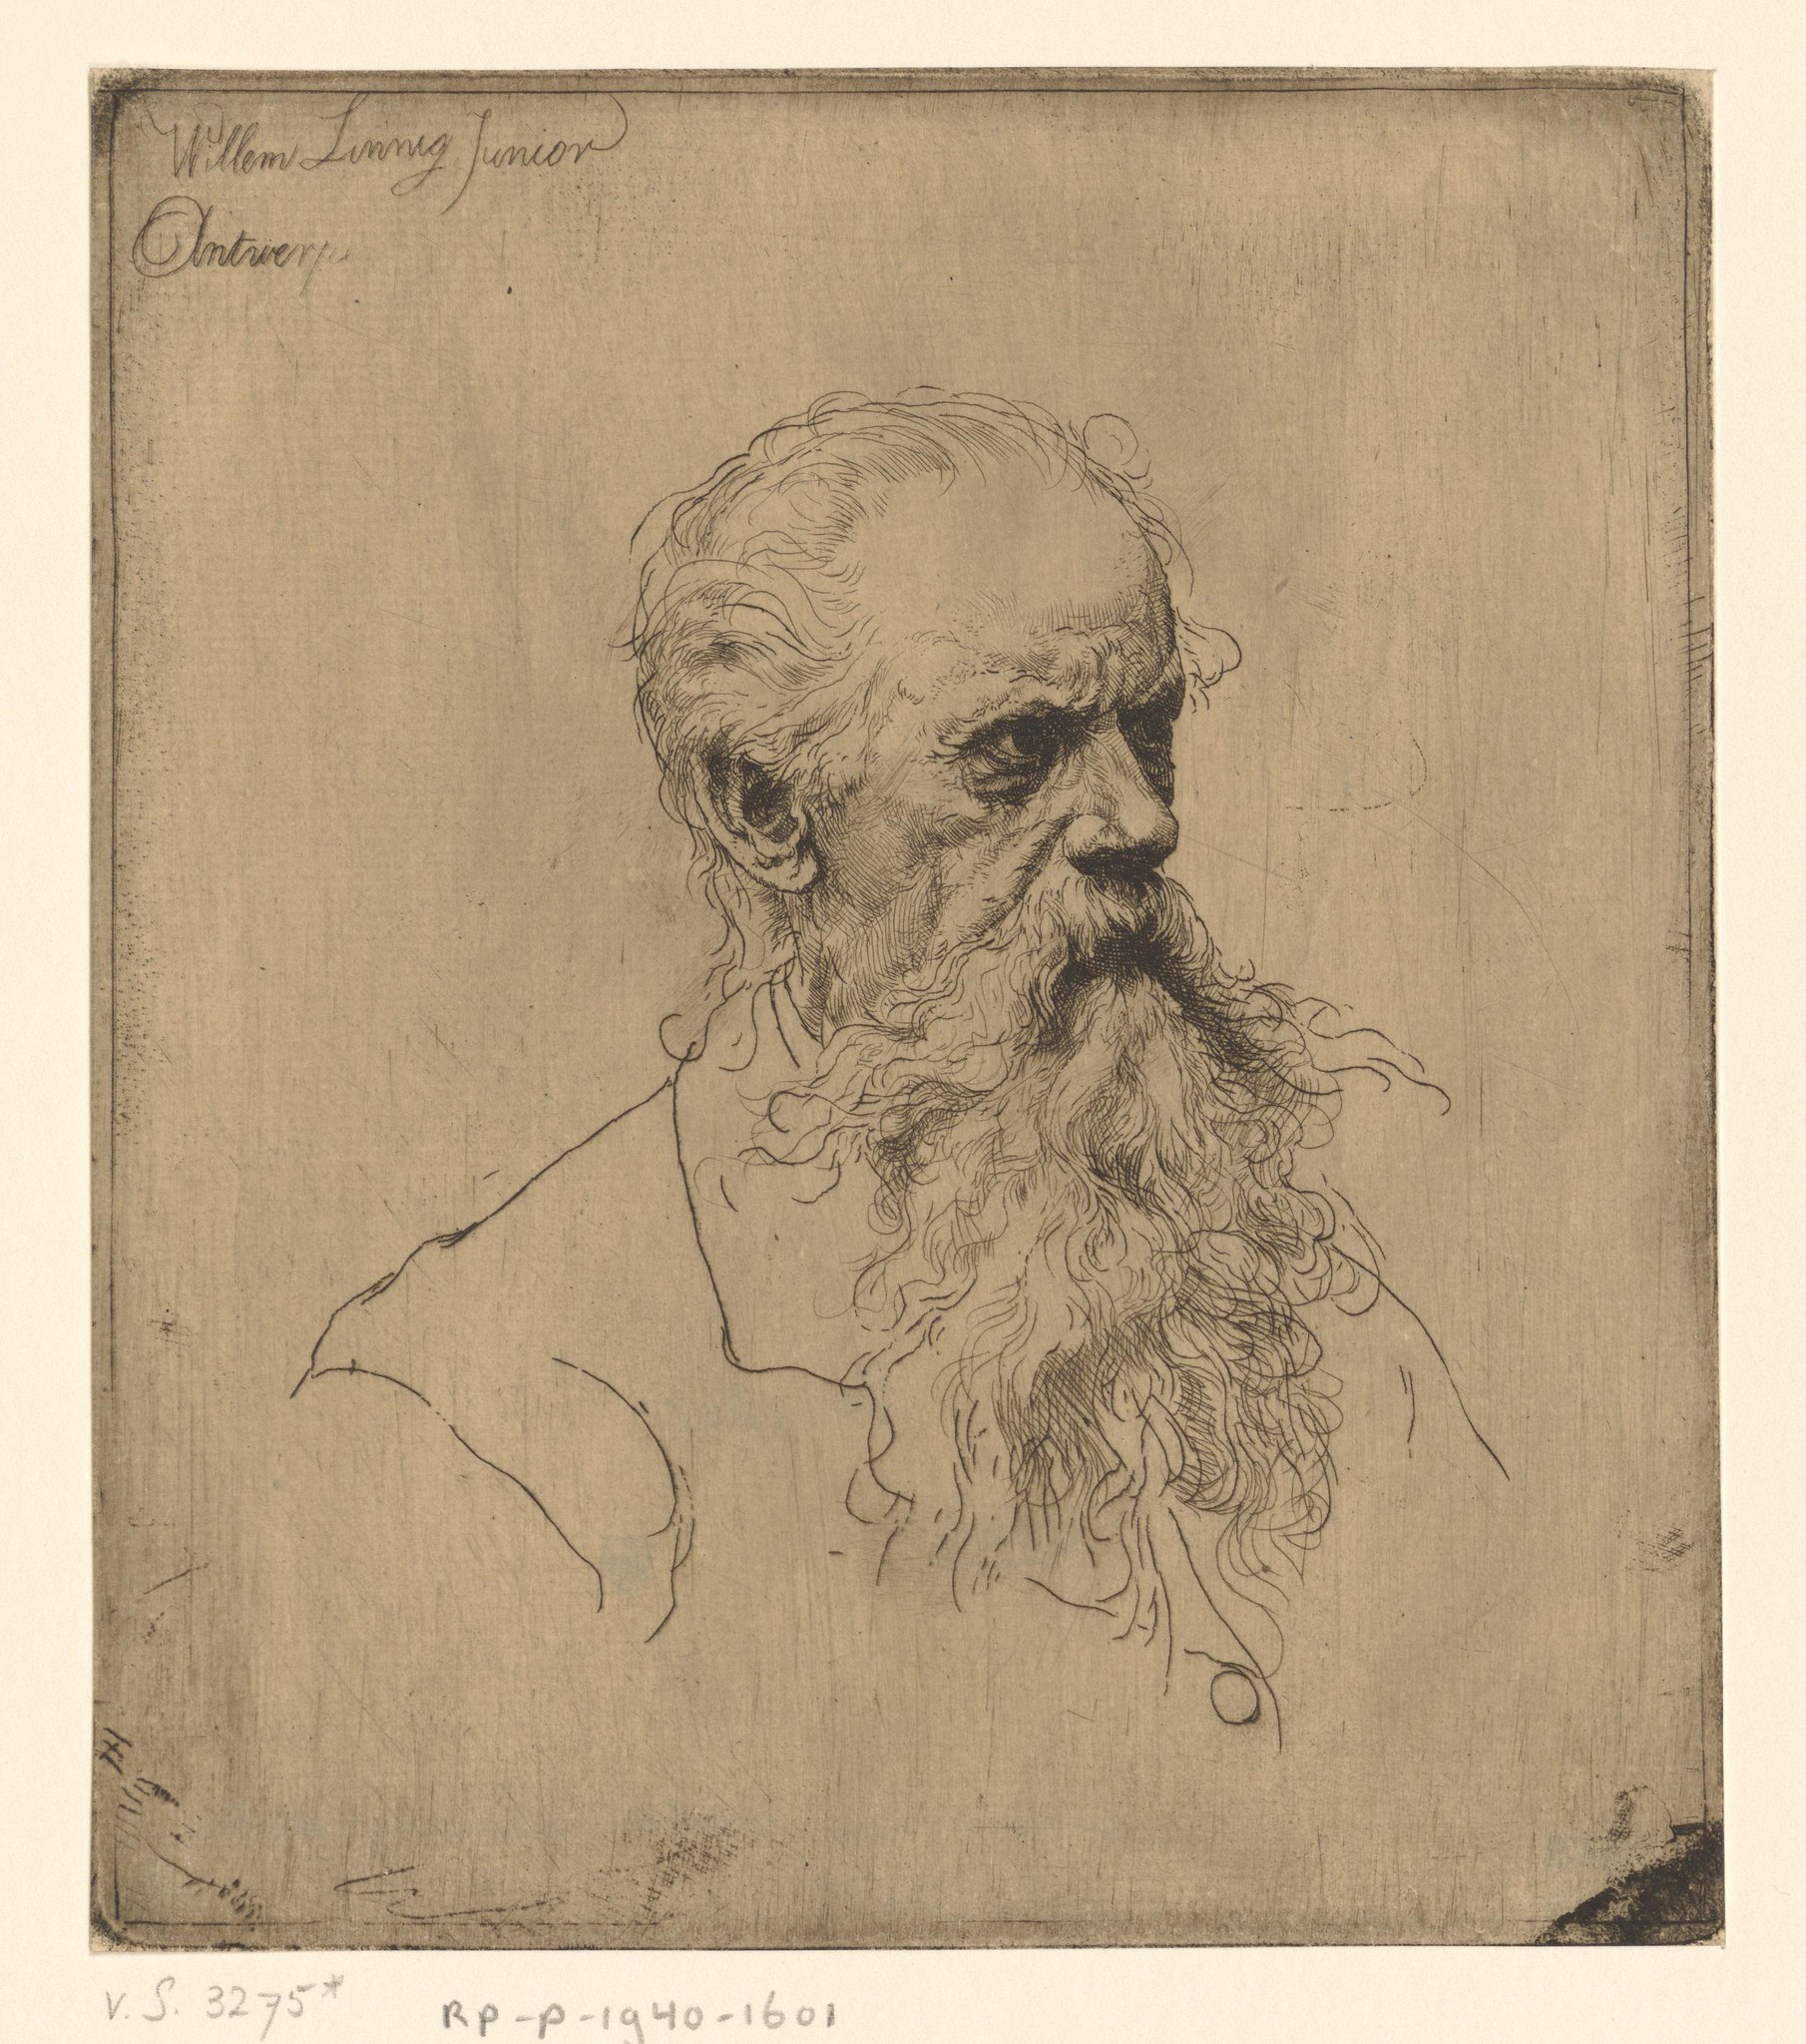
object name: print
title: Portret van Willem Linnig (I)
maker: willem linnig (ii)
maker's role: print maker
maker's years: 1842-1890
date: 1880-1890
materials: paper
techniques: etching, intaglio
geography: antwerp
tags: antwerp, print maker, willem linnig (i), historical persons, portrait, self-portrait of artist, beard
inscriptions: collector's mark: Lugt 2760, collector's mark: Lugt 2228, collector's mark: Lugt 2166